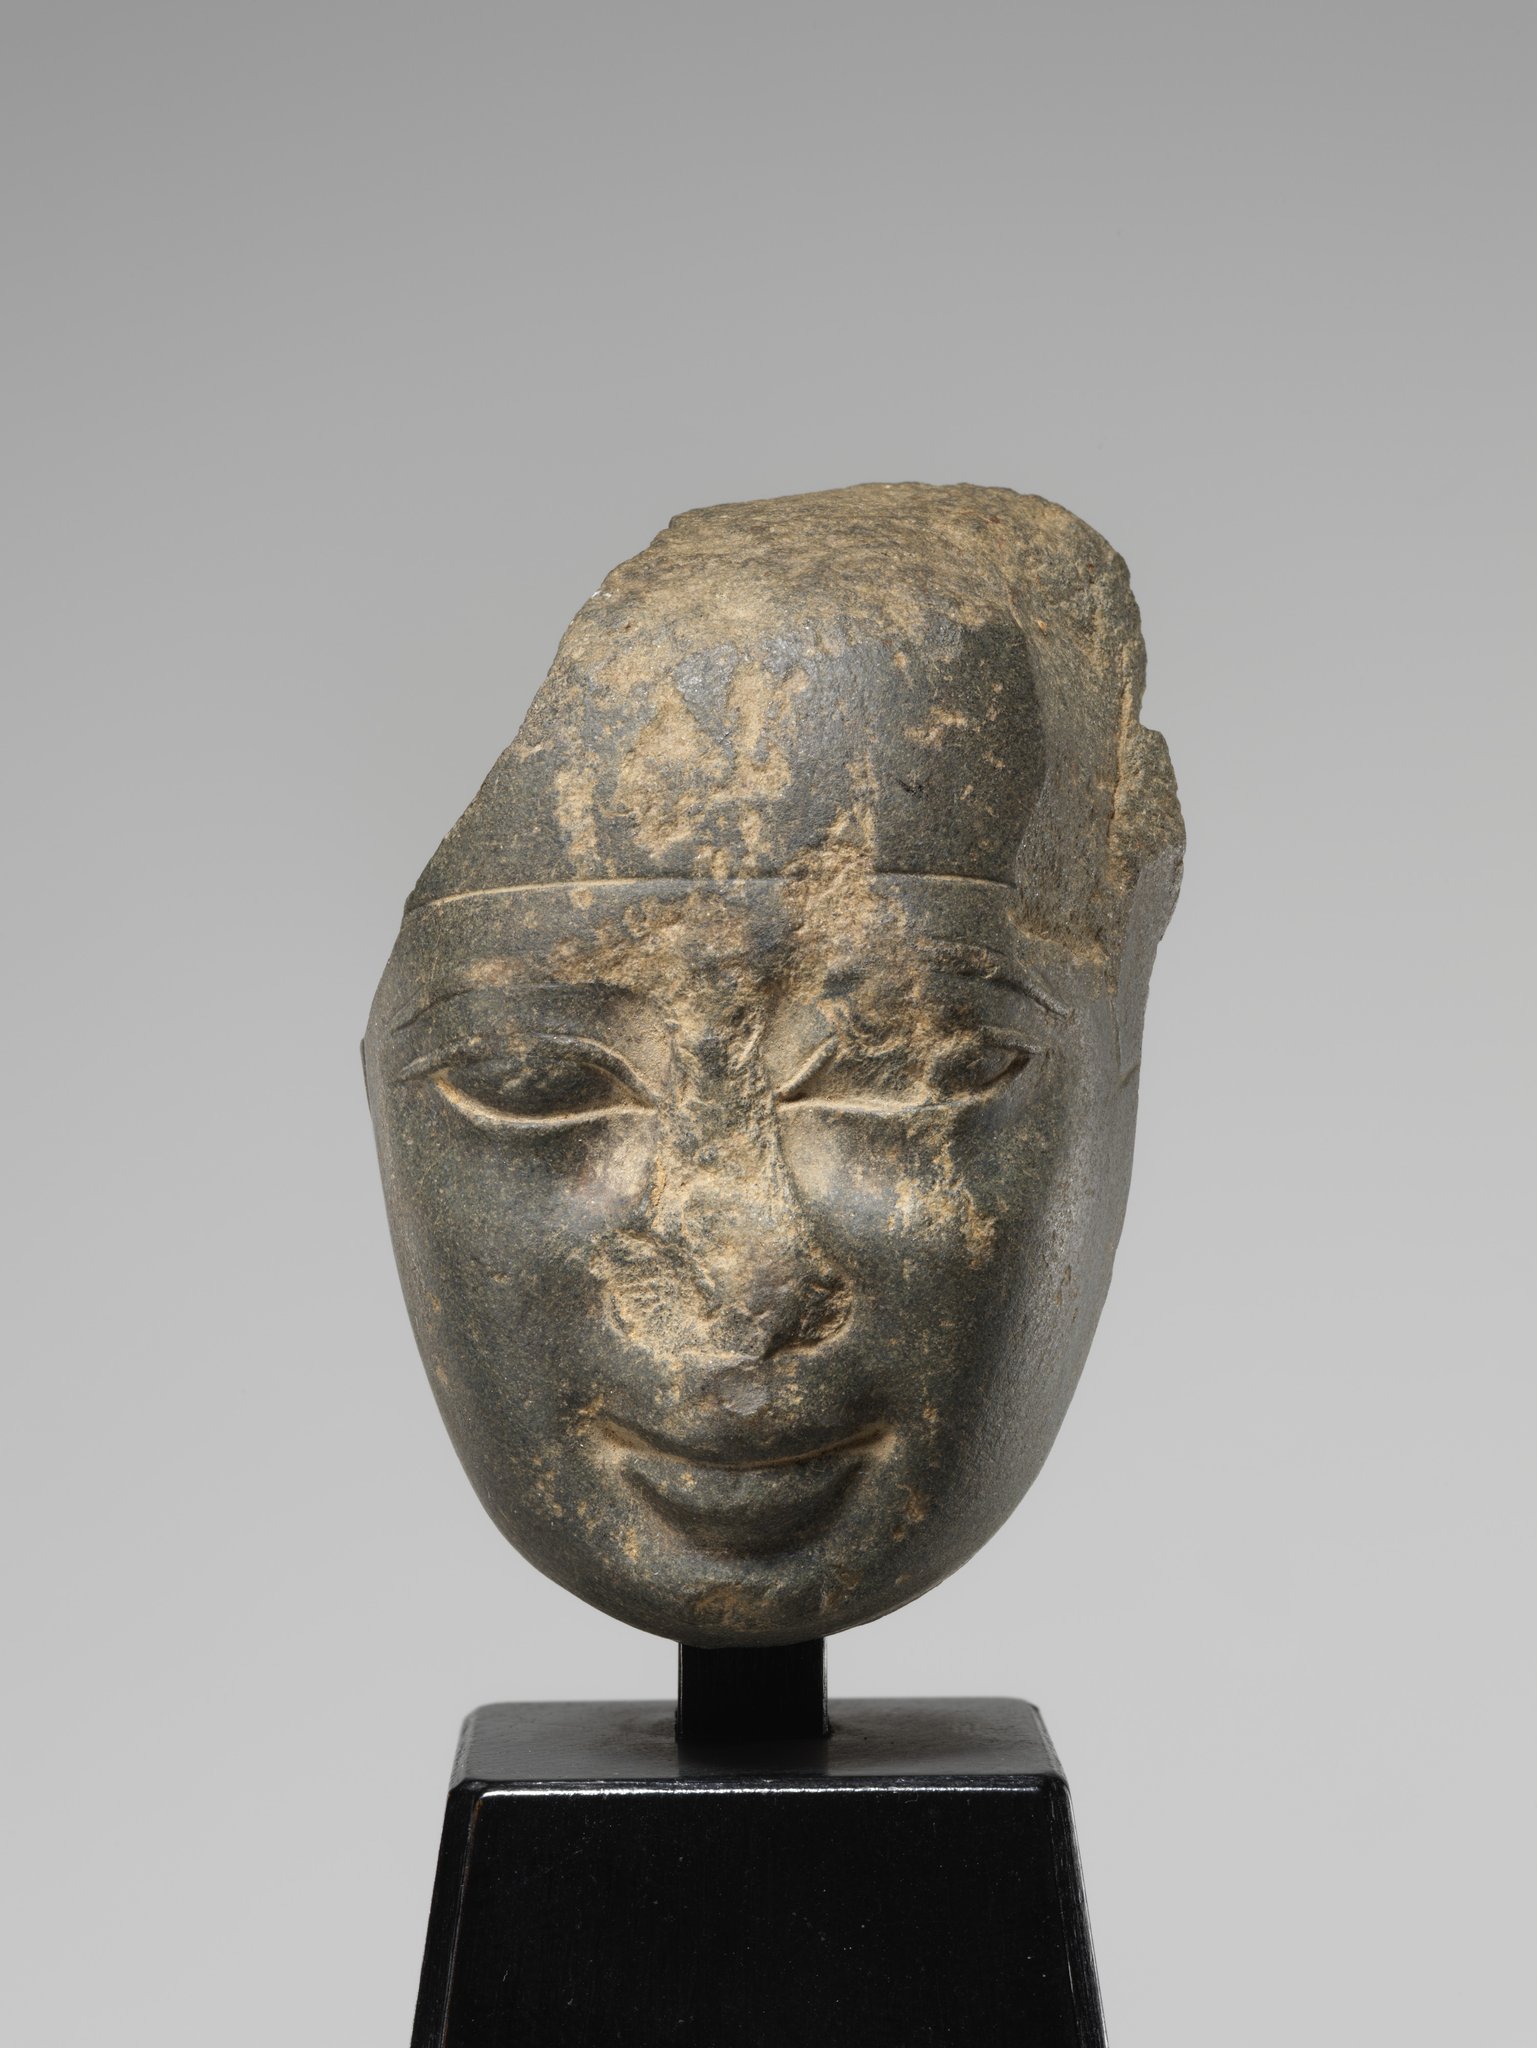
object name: head of a man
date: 595-570 BCE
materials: stone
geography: egypt